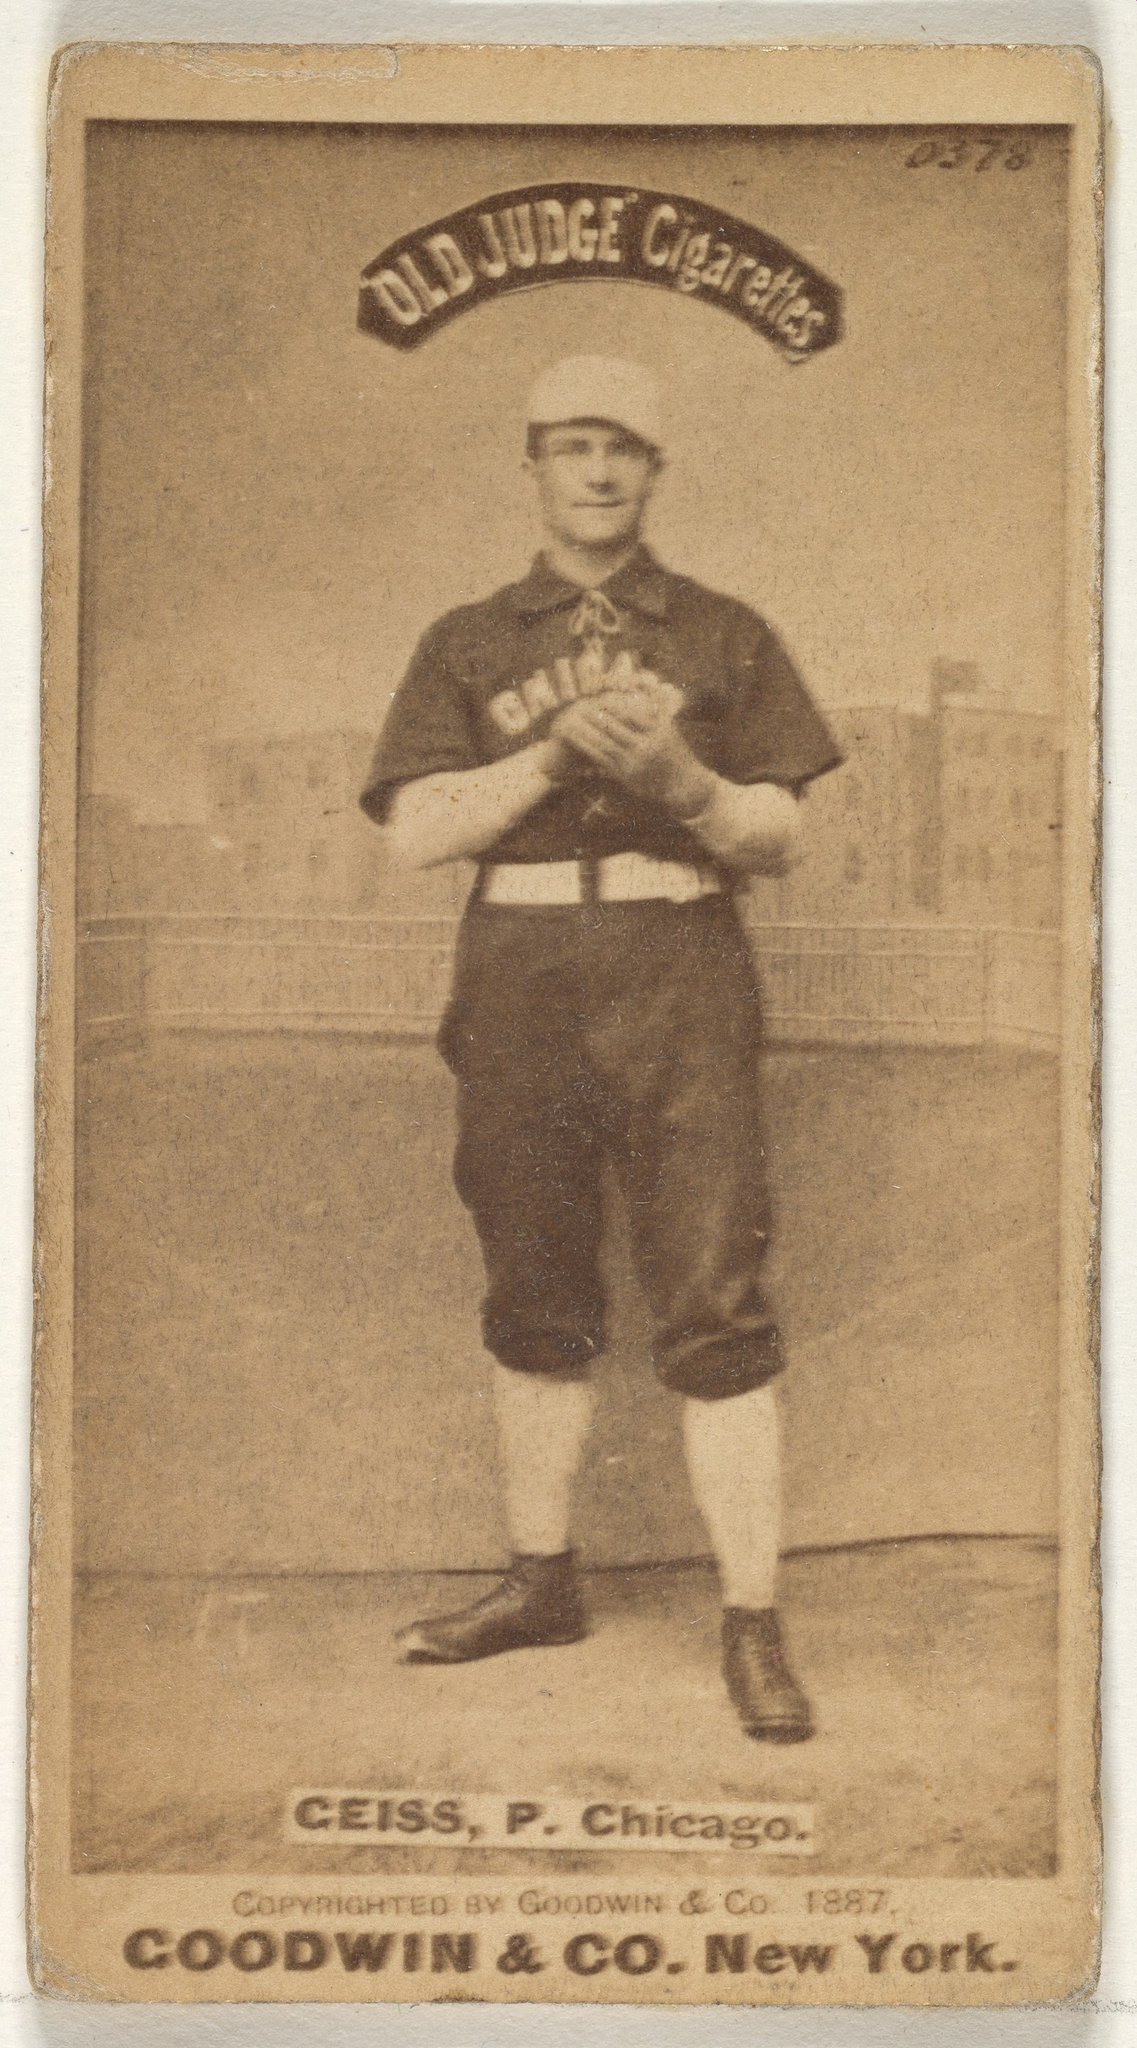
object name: baseball card, photograph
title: Ceiss, Pitcher, Chicago, from the Old Judge series (N172) for Old Judge Cigarettes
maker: goodwin & company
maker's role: publisher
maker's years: 1850-1950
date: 1887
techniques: albumen silver print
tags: men,portraits,baseball,athletes